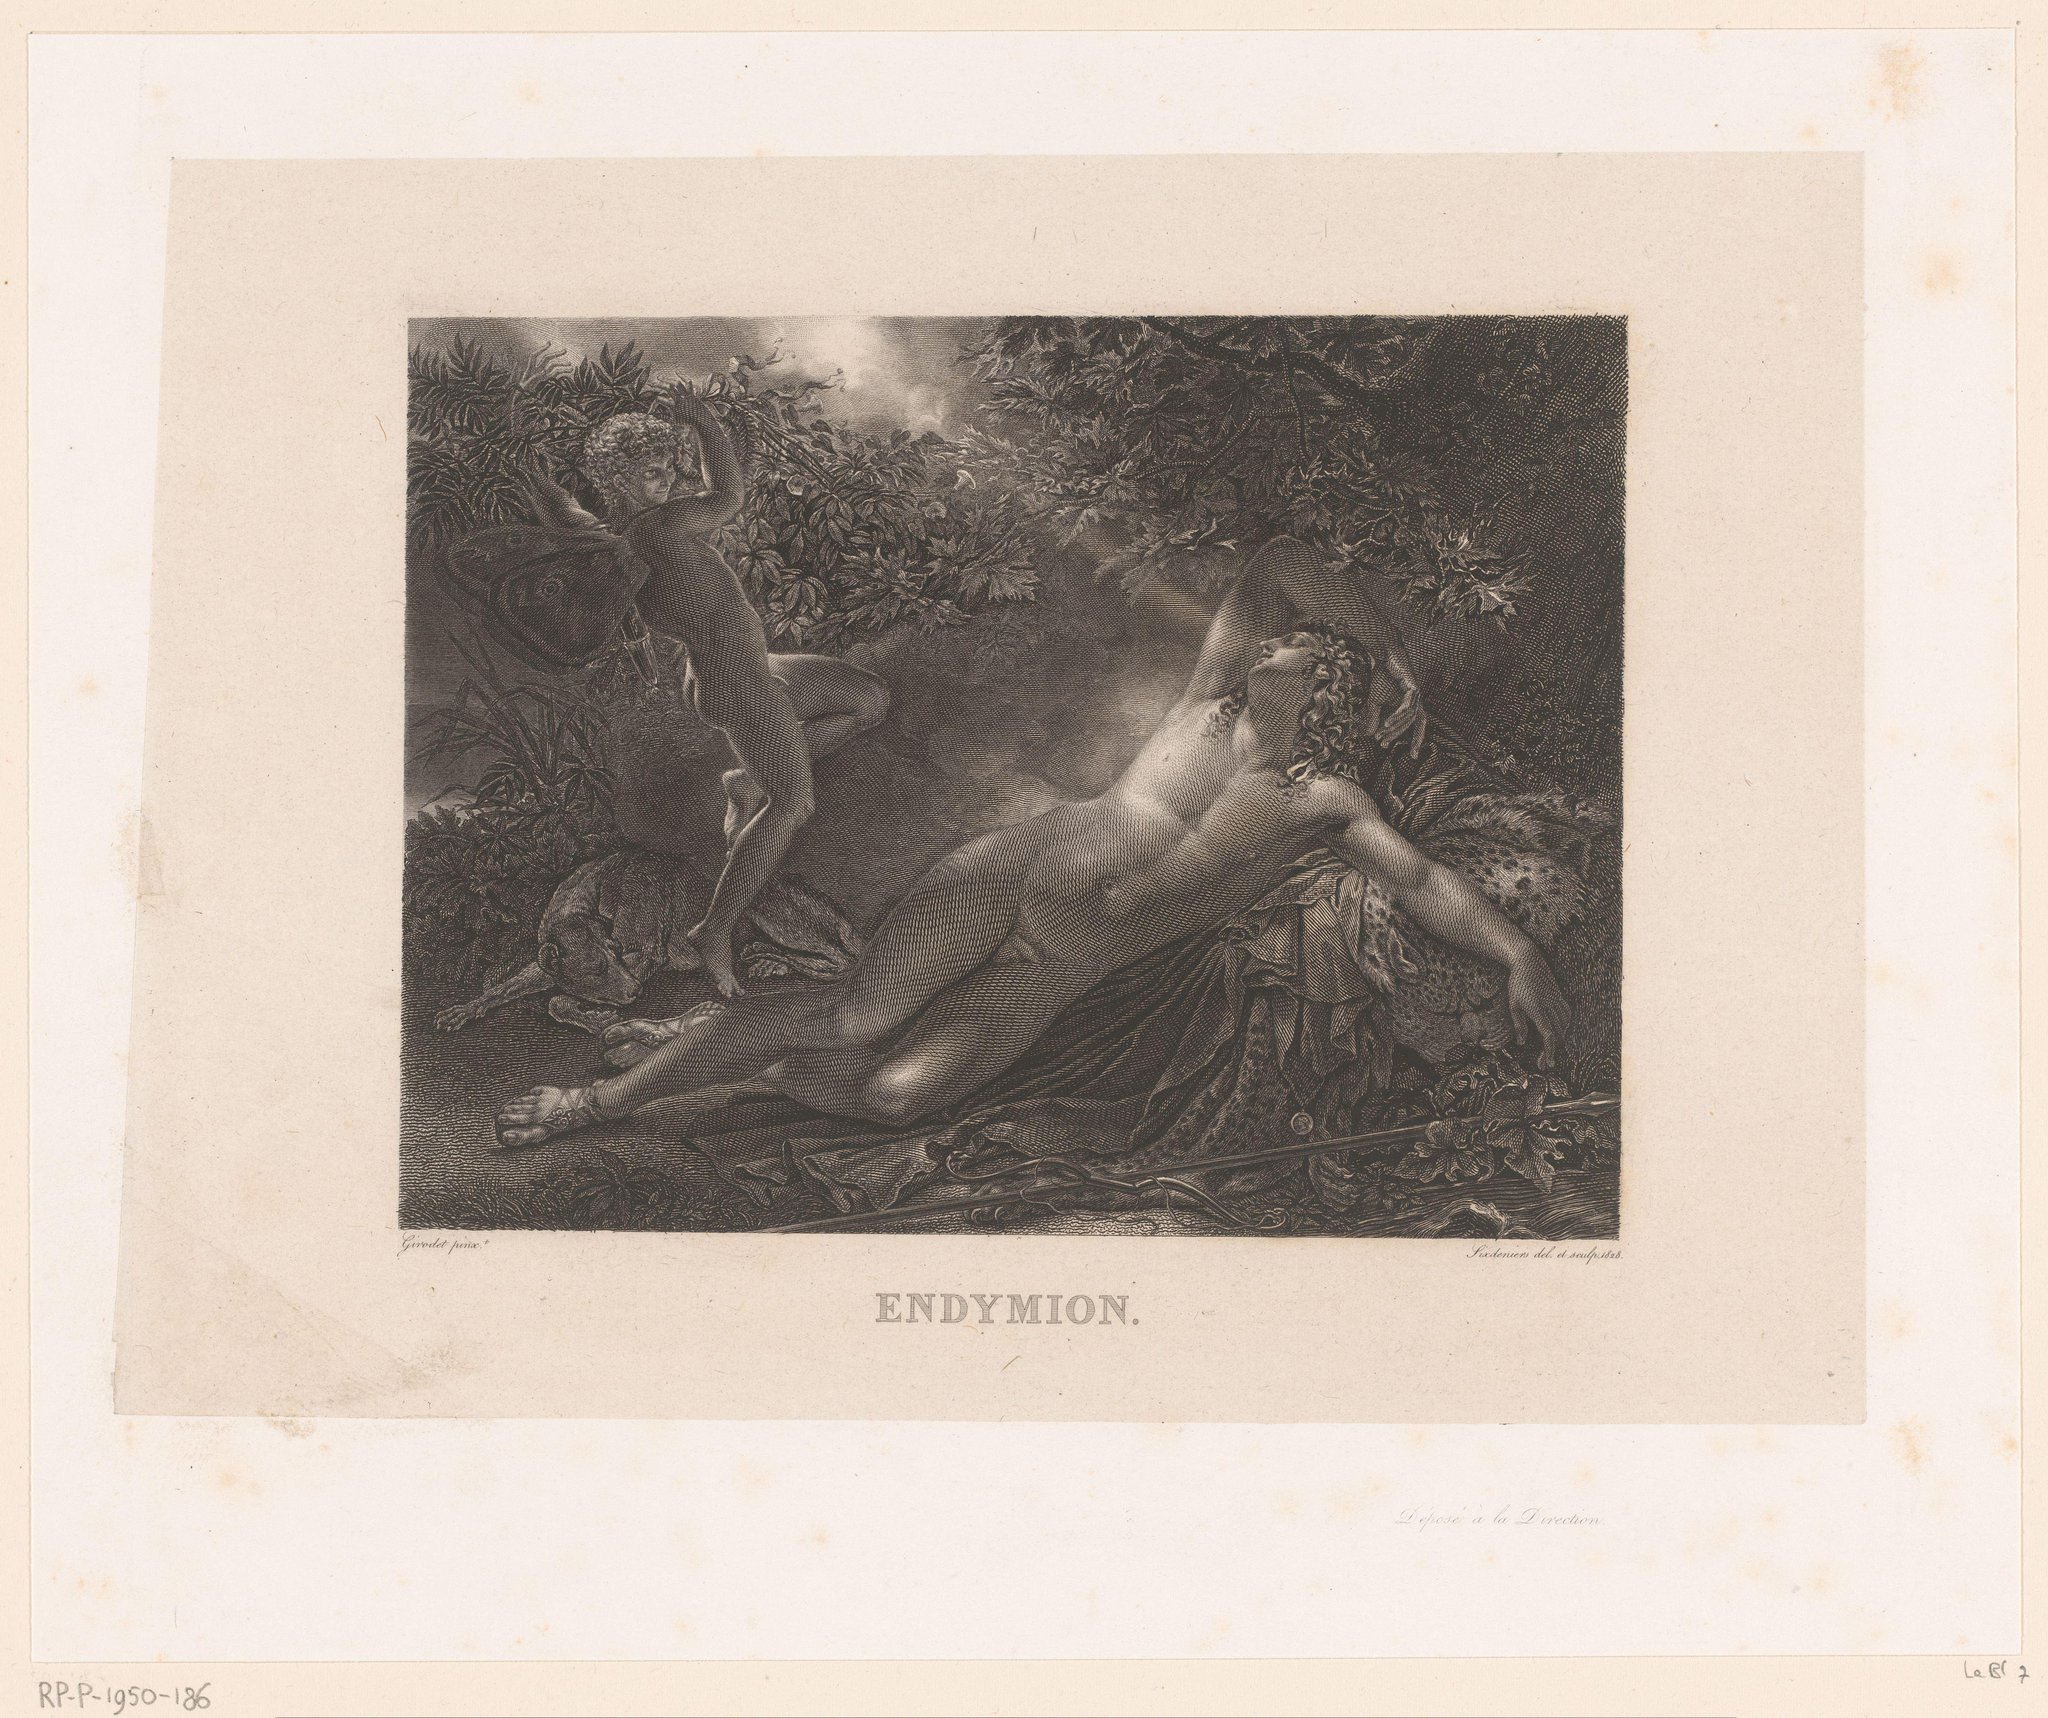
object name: print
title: Endymion bezocht door Diana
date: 1803-1846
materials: paper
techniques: engraving, etching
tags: diana (luna) visiting the sleeping endymion, (story of) cupid, amor (eros)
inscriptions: collector's mark: Lugt 2228